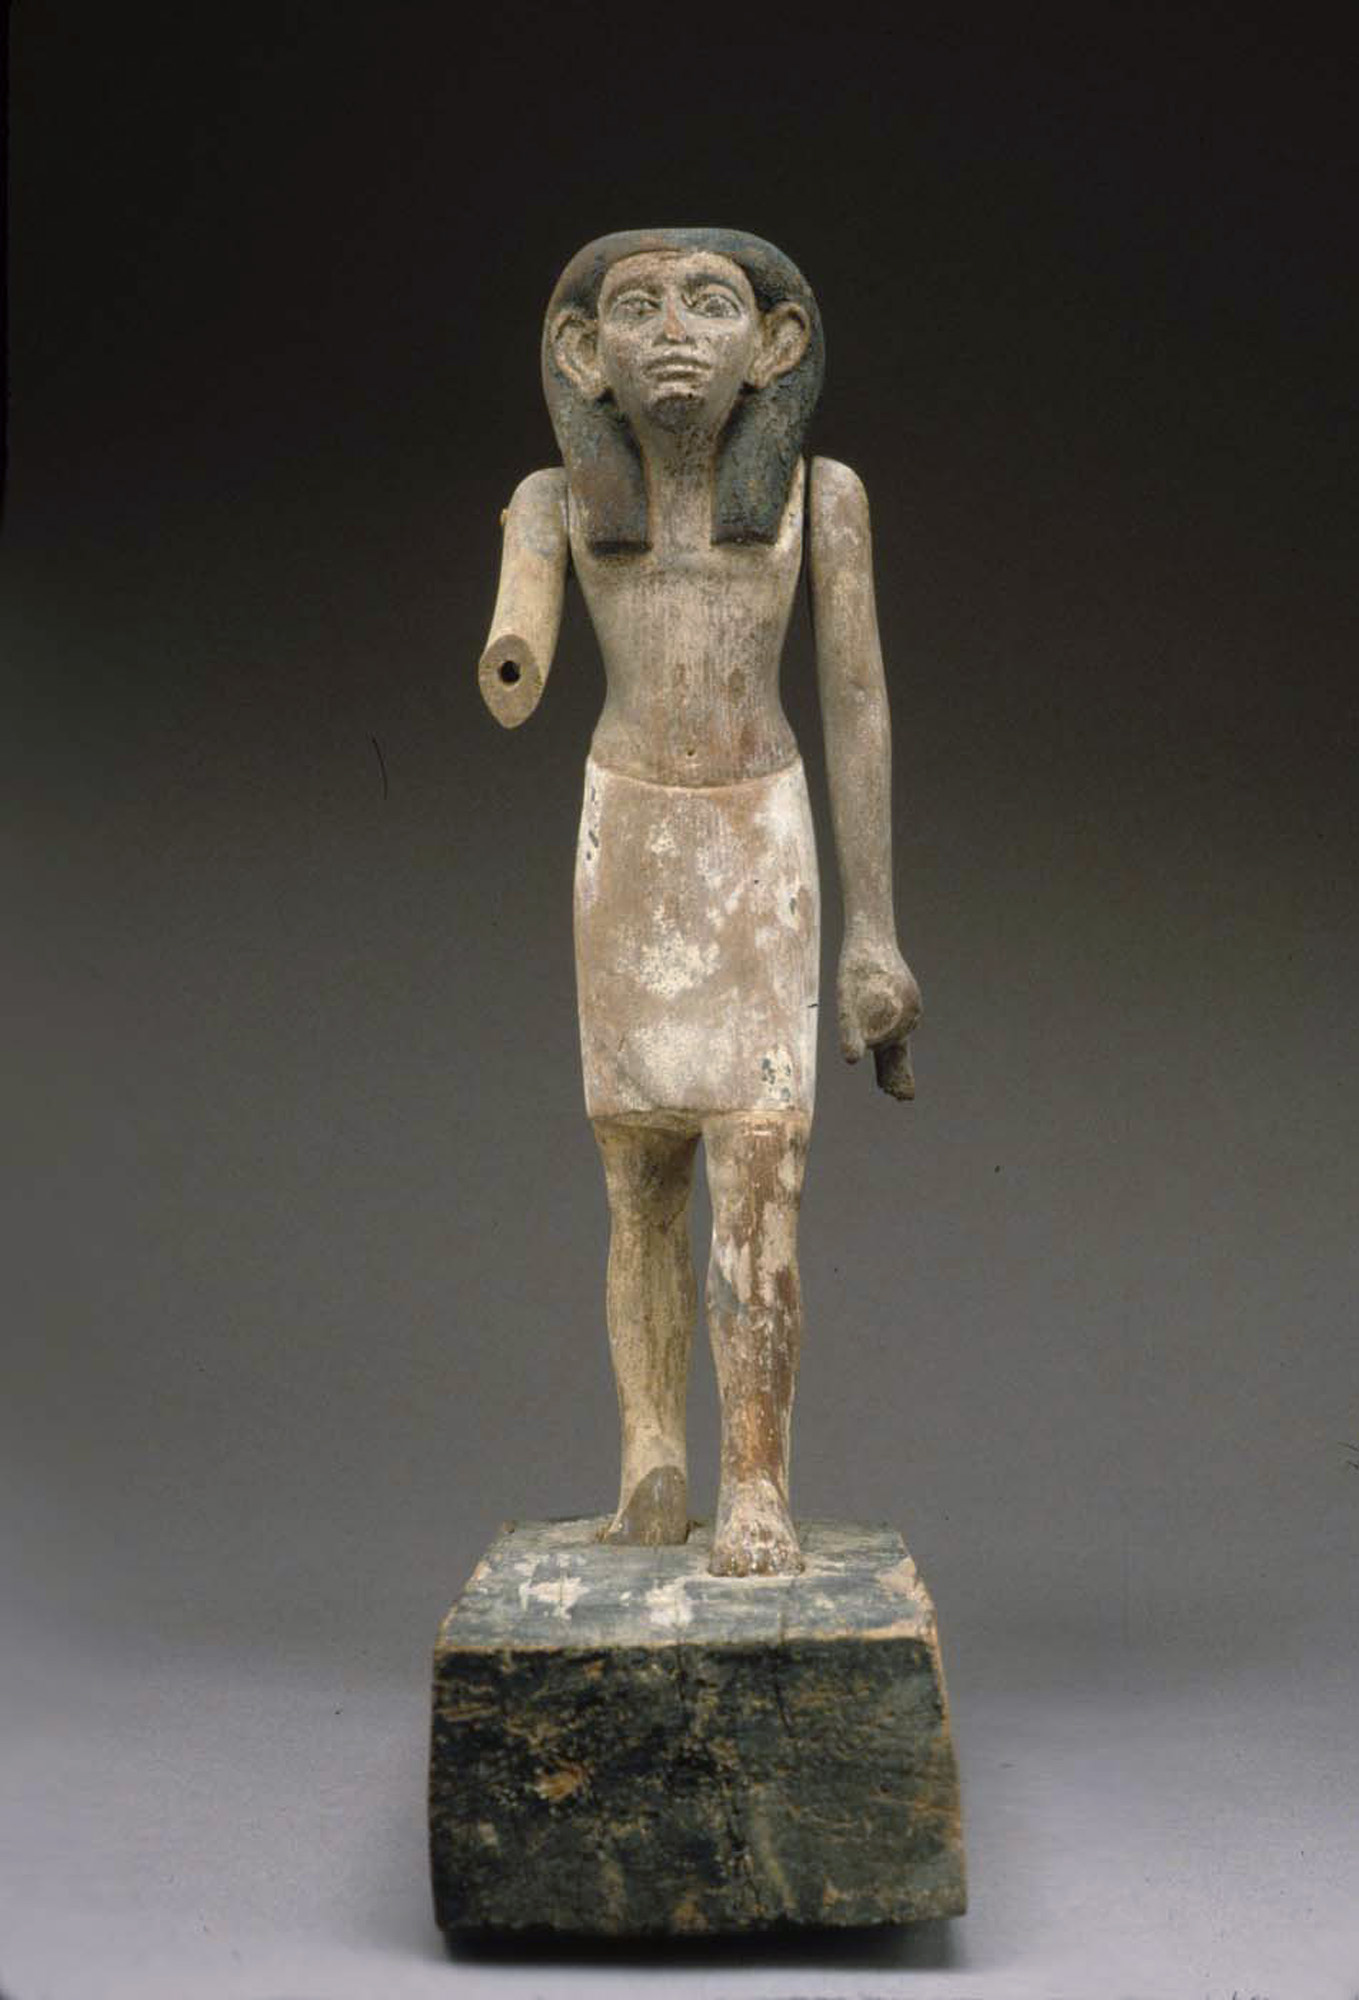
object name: statuette, male striding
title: Male figure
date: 1900-1850 BCE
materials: paint, wood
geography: egypt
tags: men